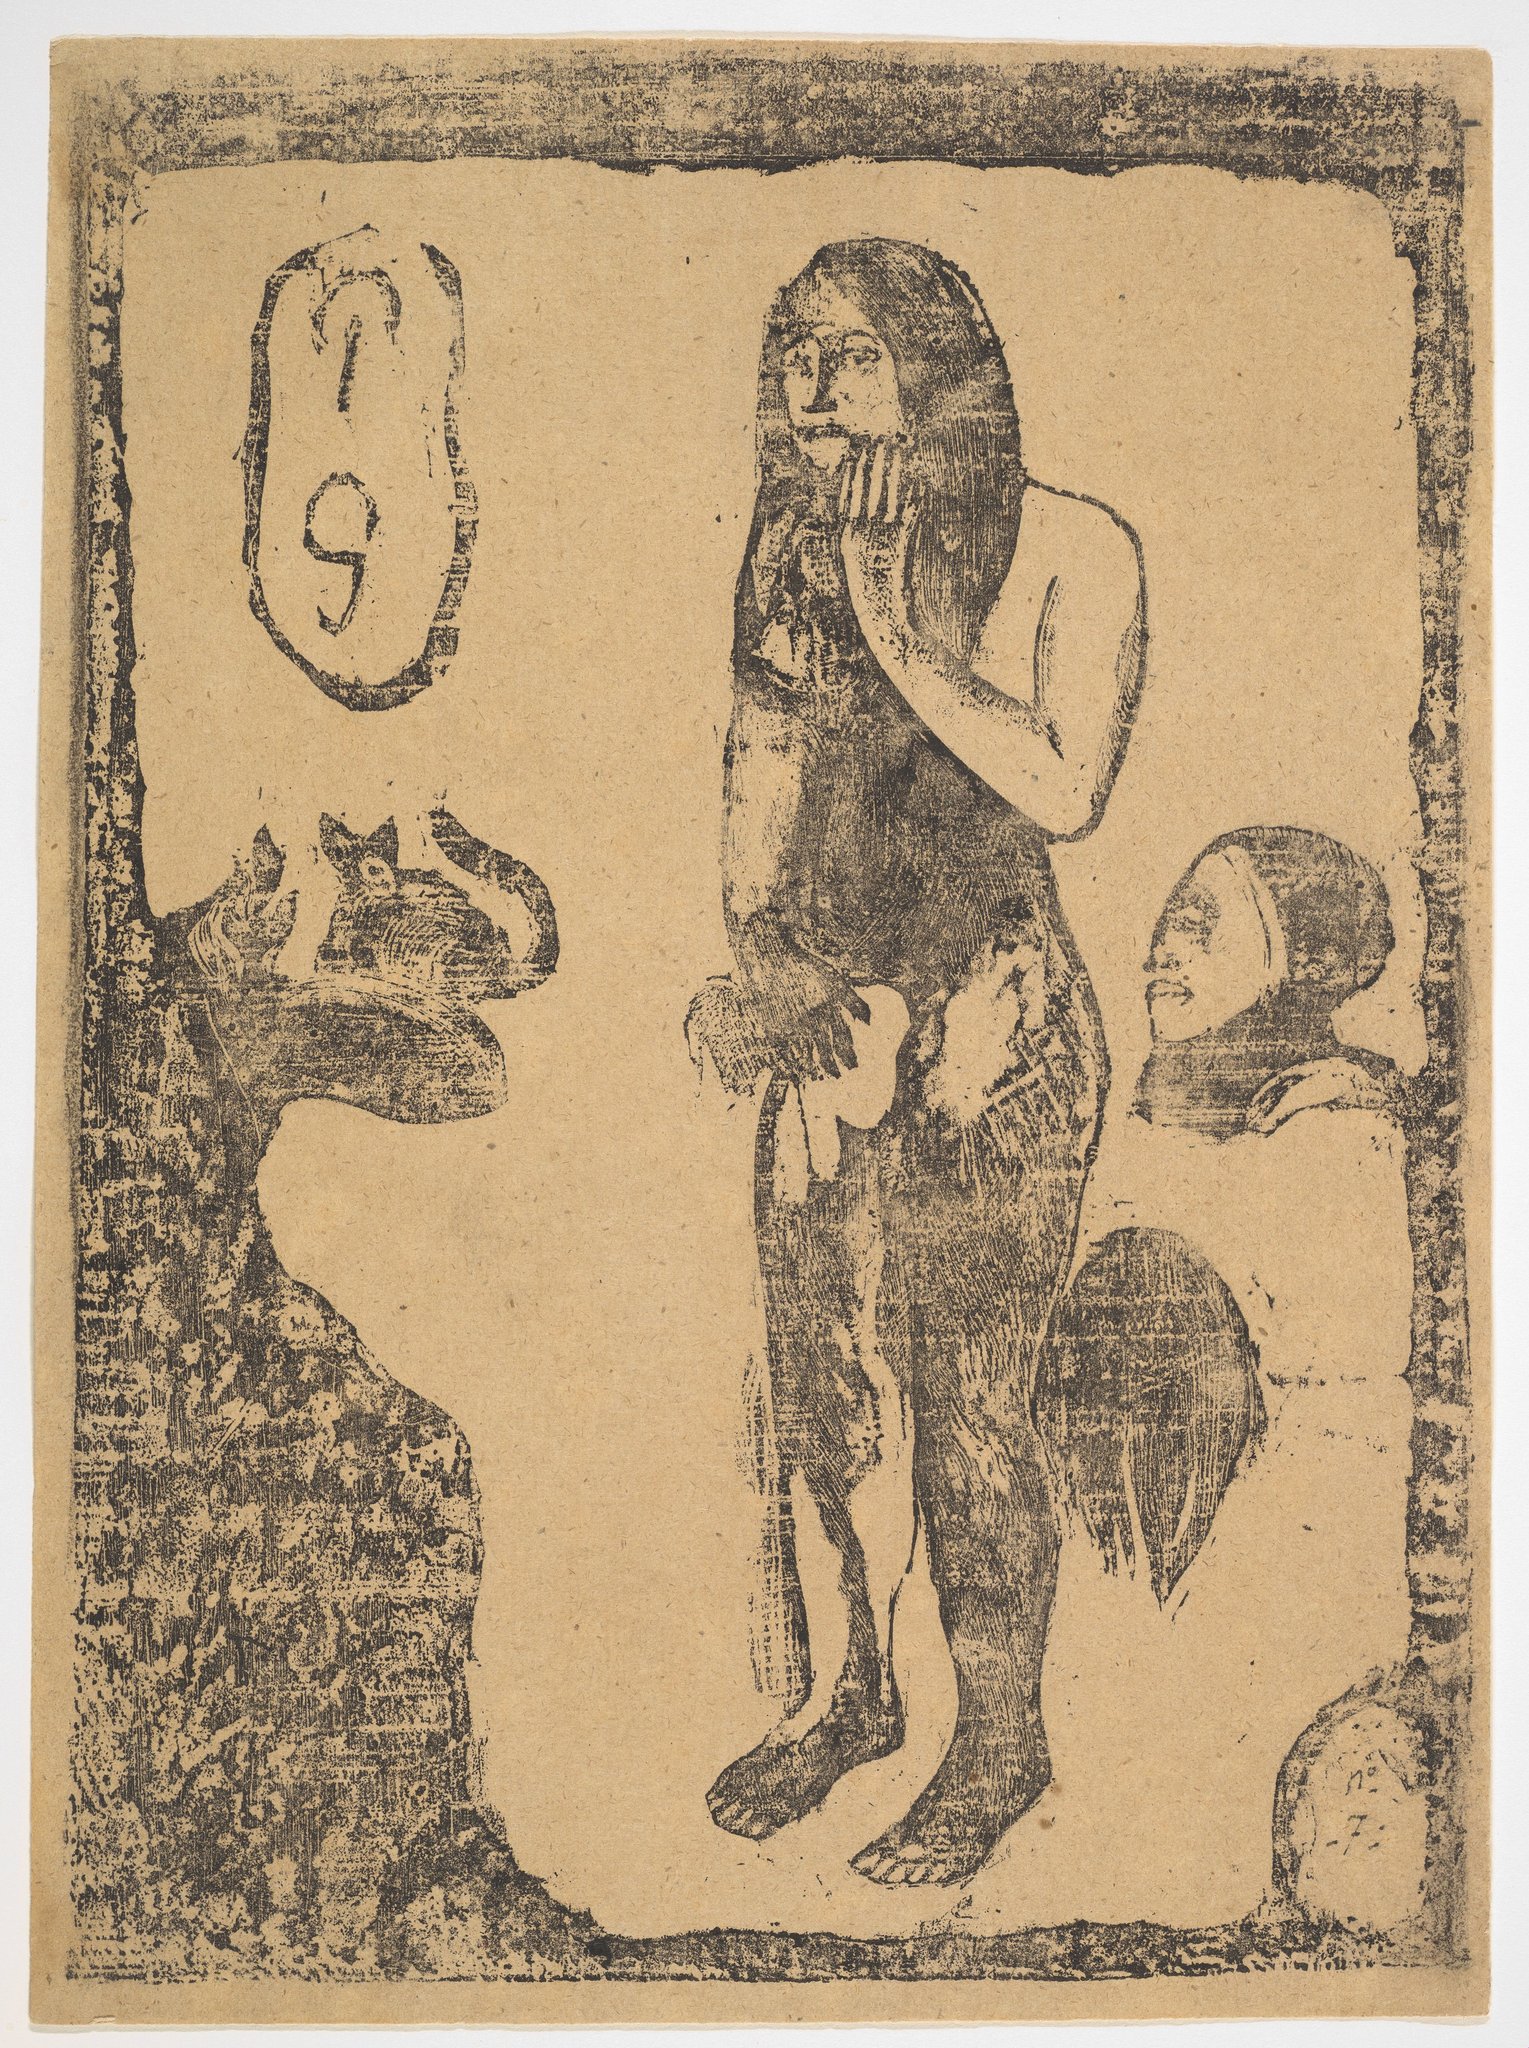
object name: print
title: Eve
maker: paul gauguin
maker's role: artist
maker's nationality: french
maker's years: 1848-1903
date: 1898-1899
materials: ink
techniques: printing, woodcut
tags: eve